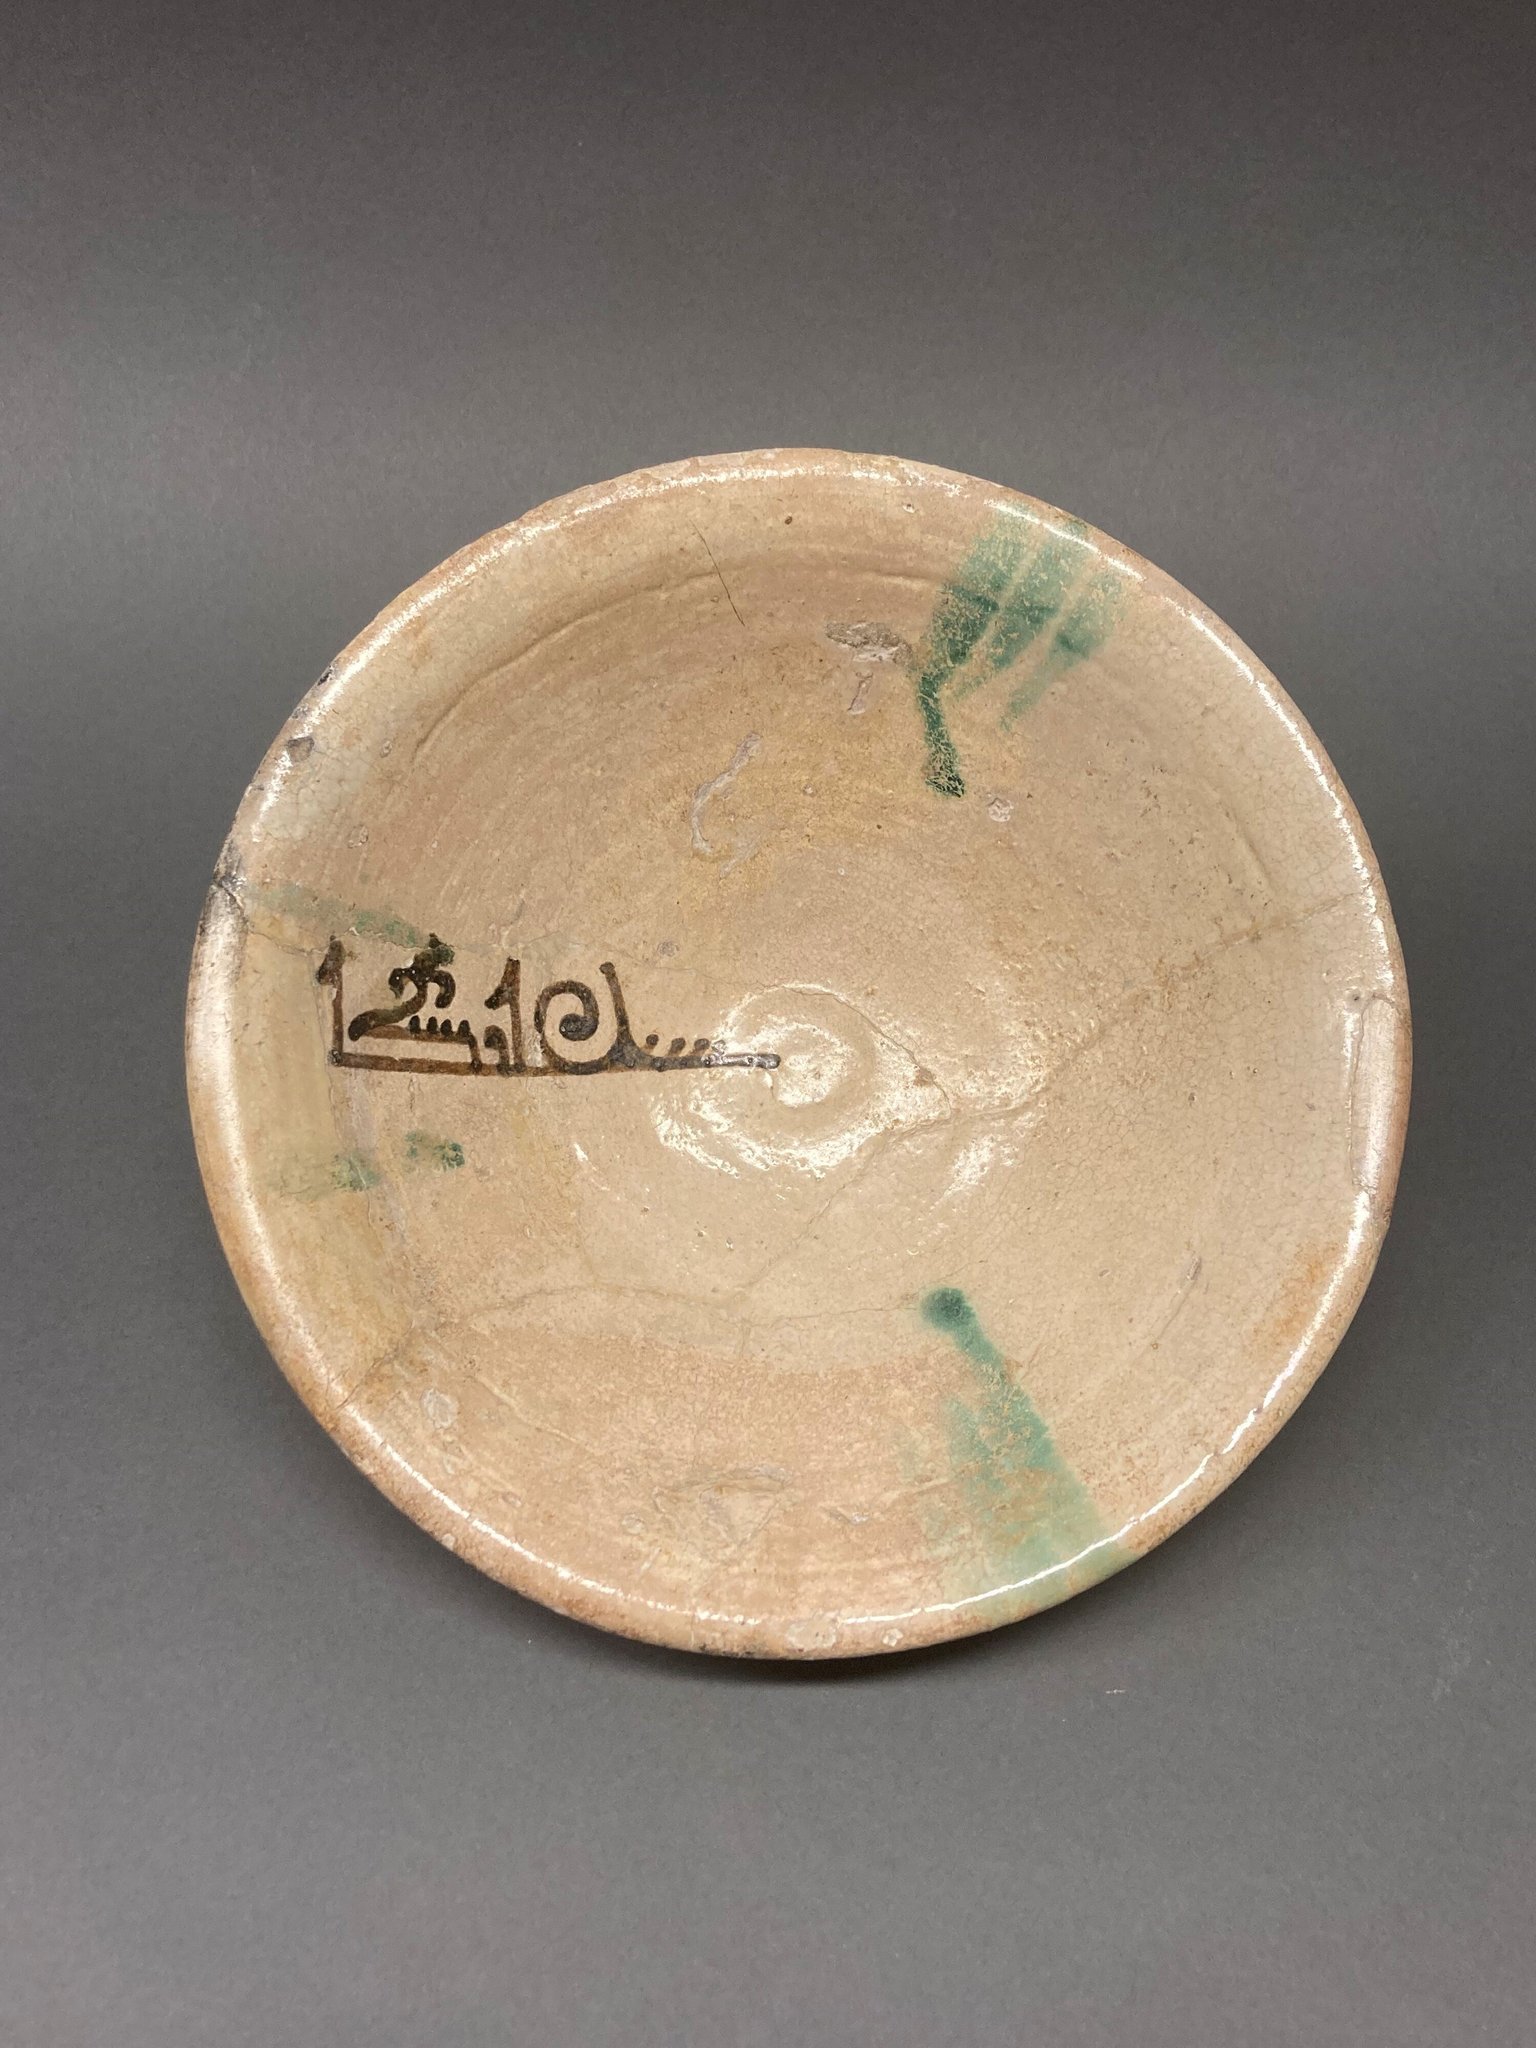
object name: bowl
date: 801-900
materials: earthenware, glaze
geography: iran